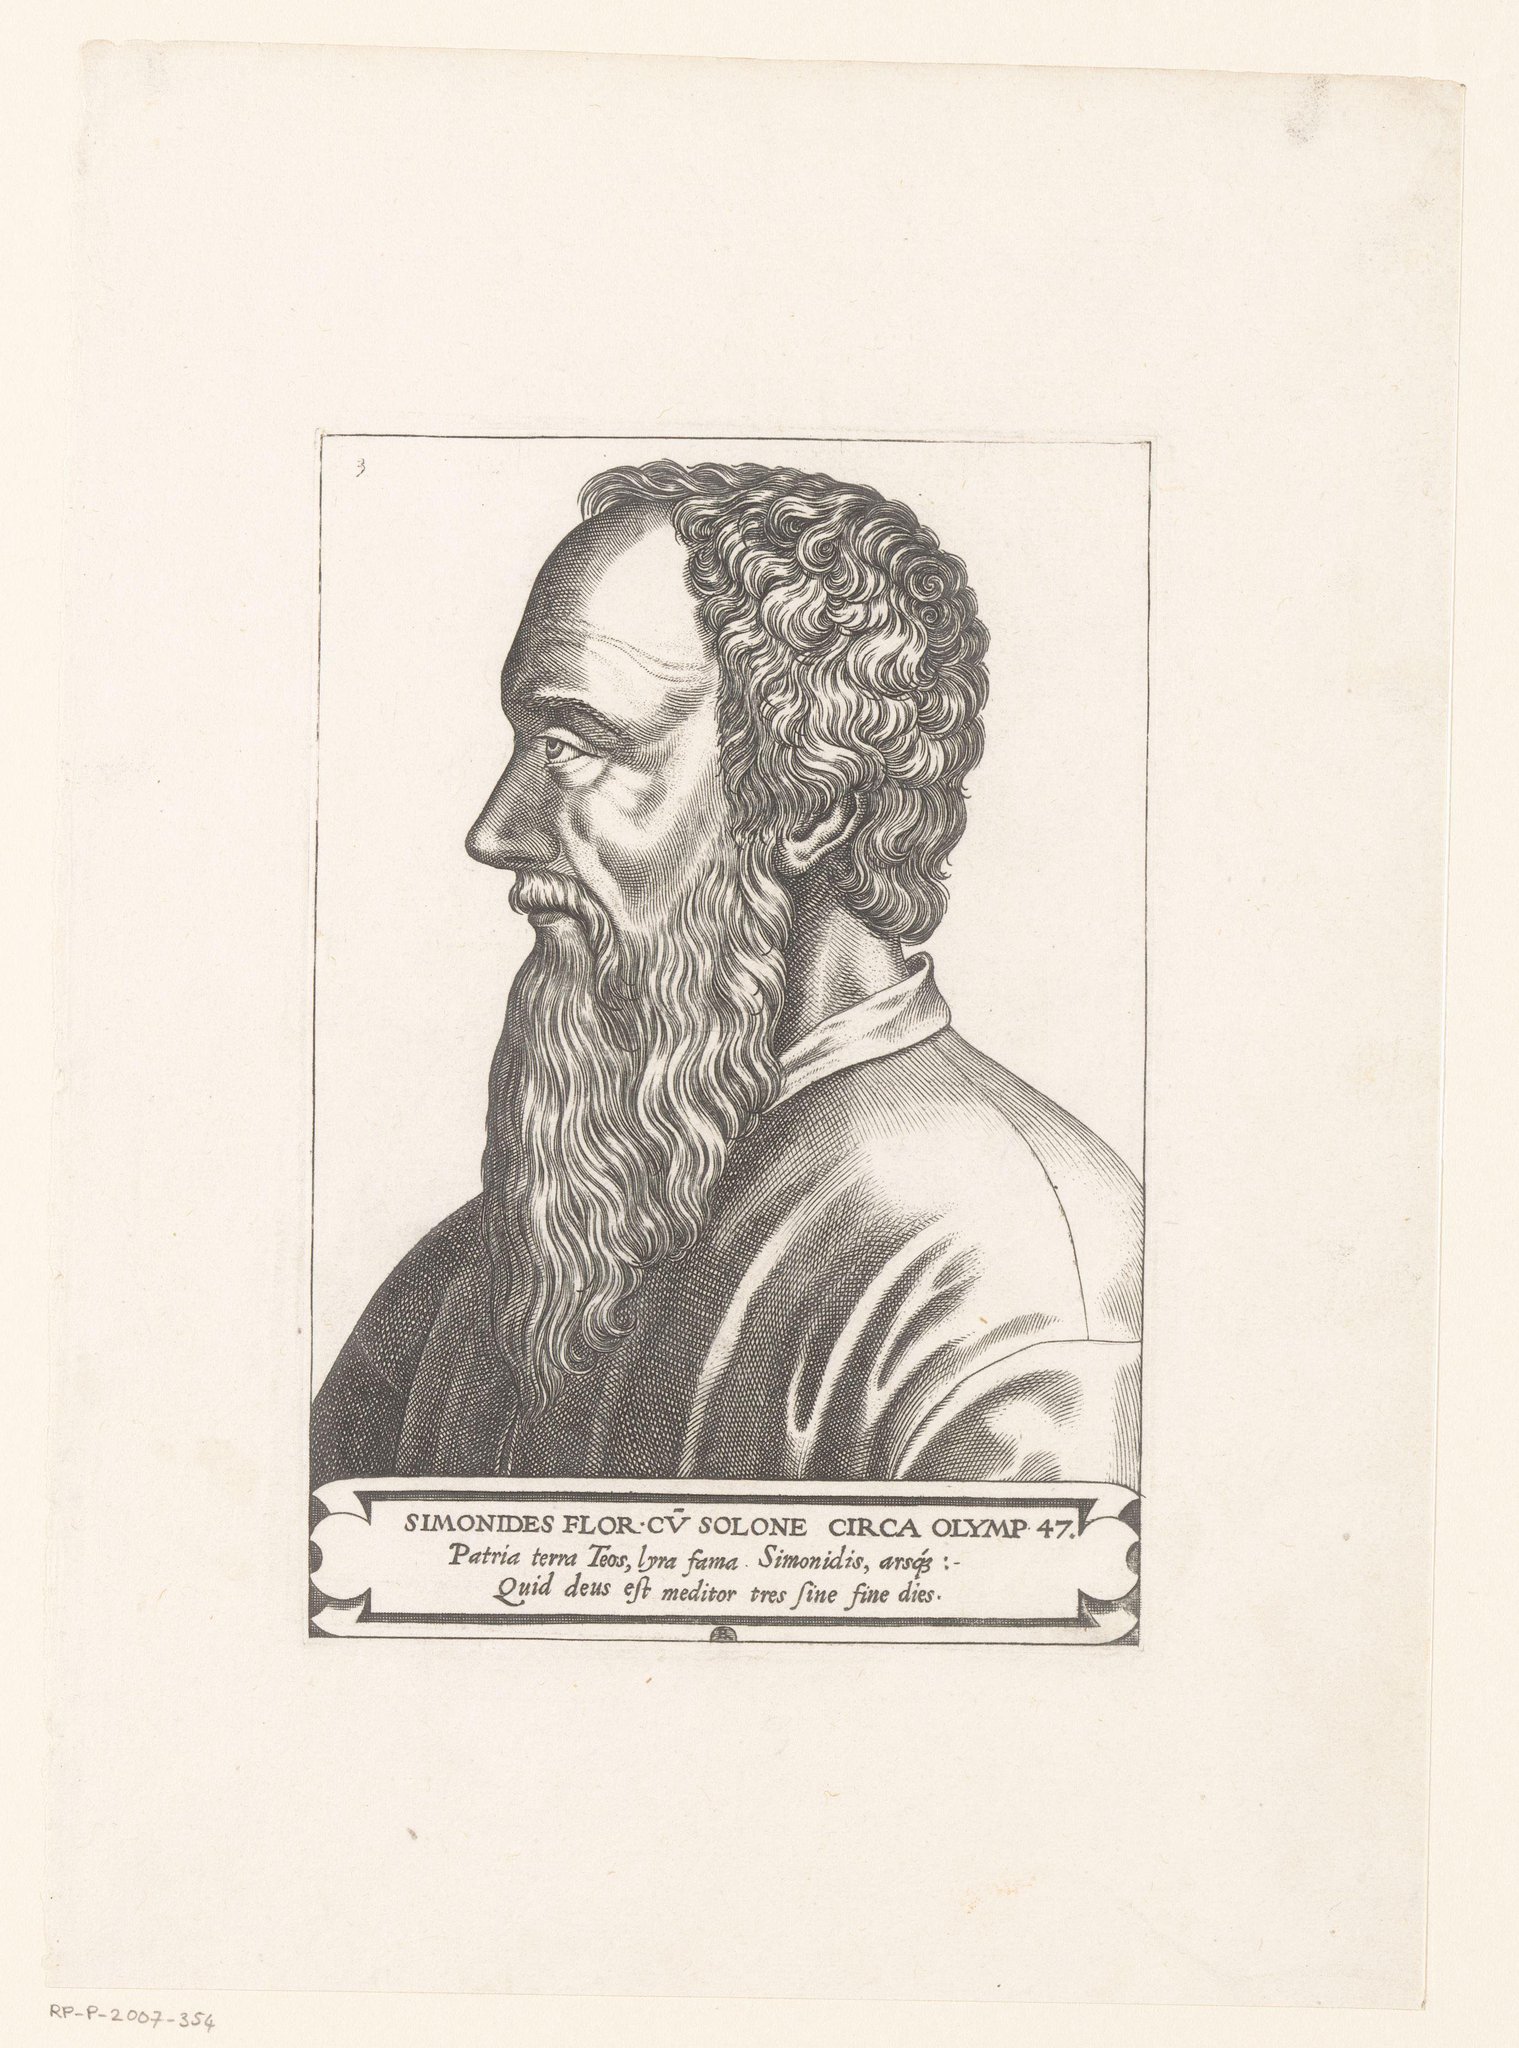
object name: print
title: Portretten van Griekse en Romeinse filosofen en schrijvers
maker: rené boyvin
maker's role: print maker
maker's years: 1525-1598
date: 1566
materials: paper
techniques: engraving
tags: male persons from classical history (simonides), historical persons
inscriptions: collector's mark: Lugt 2760, collector's mark: Lugt 2228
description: Maakt deel uit van een serie van twaalf portretten van Griekse en Romeinse filosofen, getiteld 'Illustrium philosophorum et poetarum effigies', uitgegeven in 1566 door P. de Roville in Parijs.